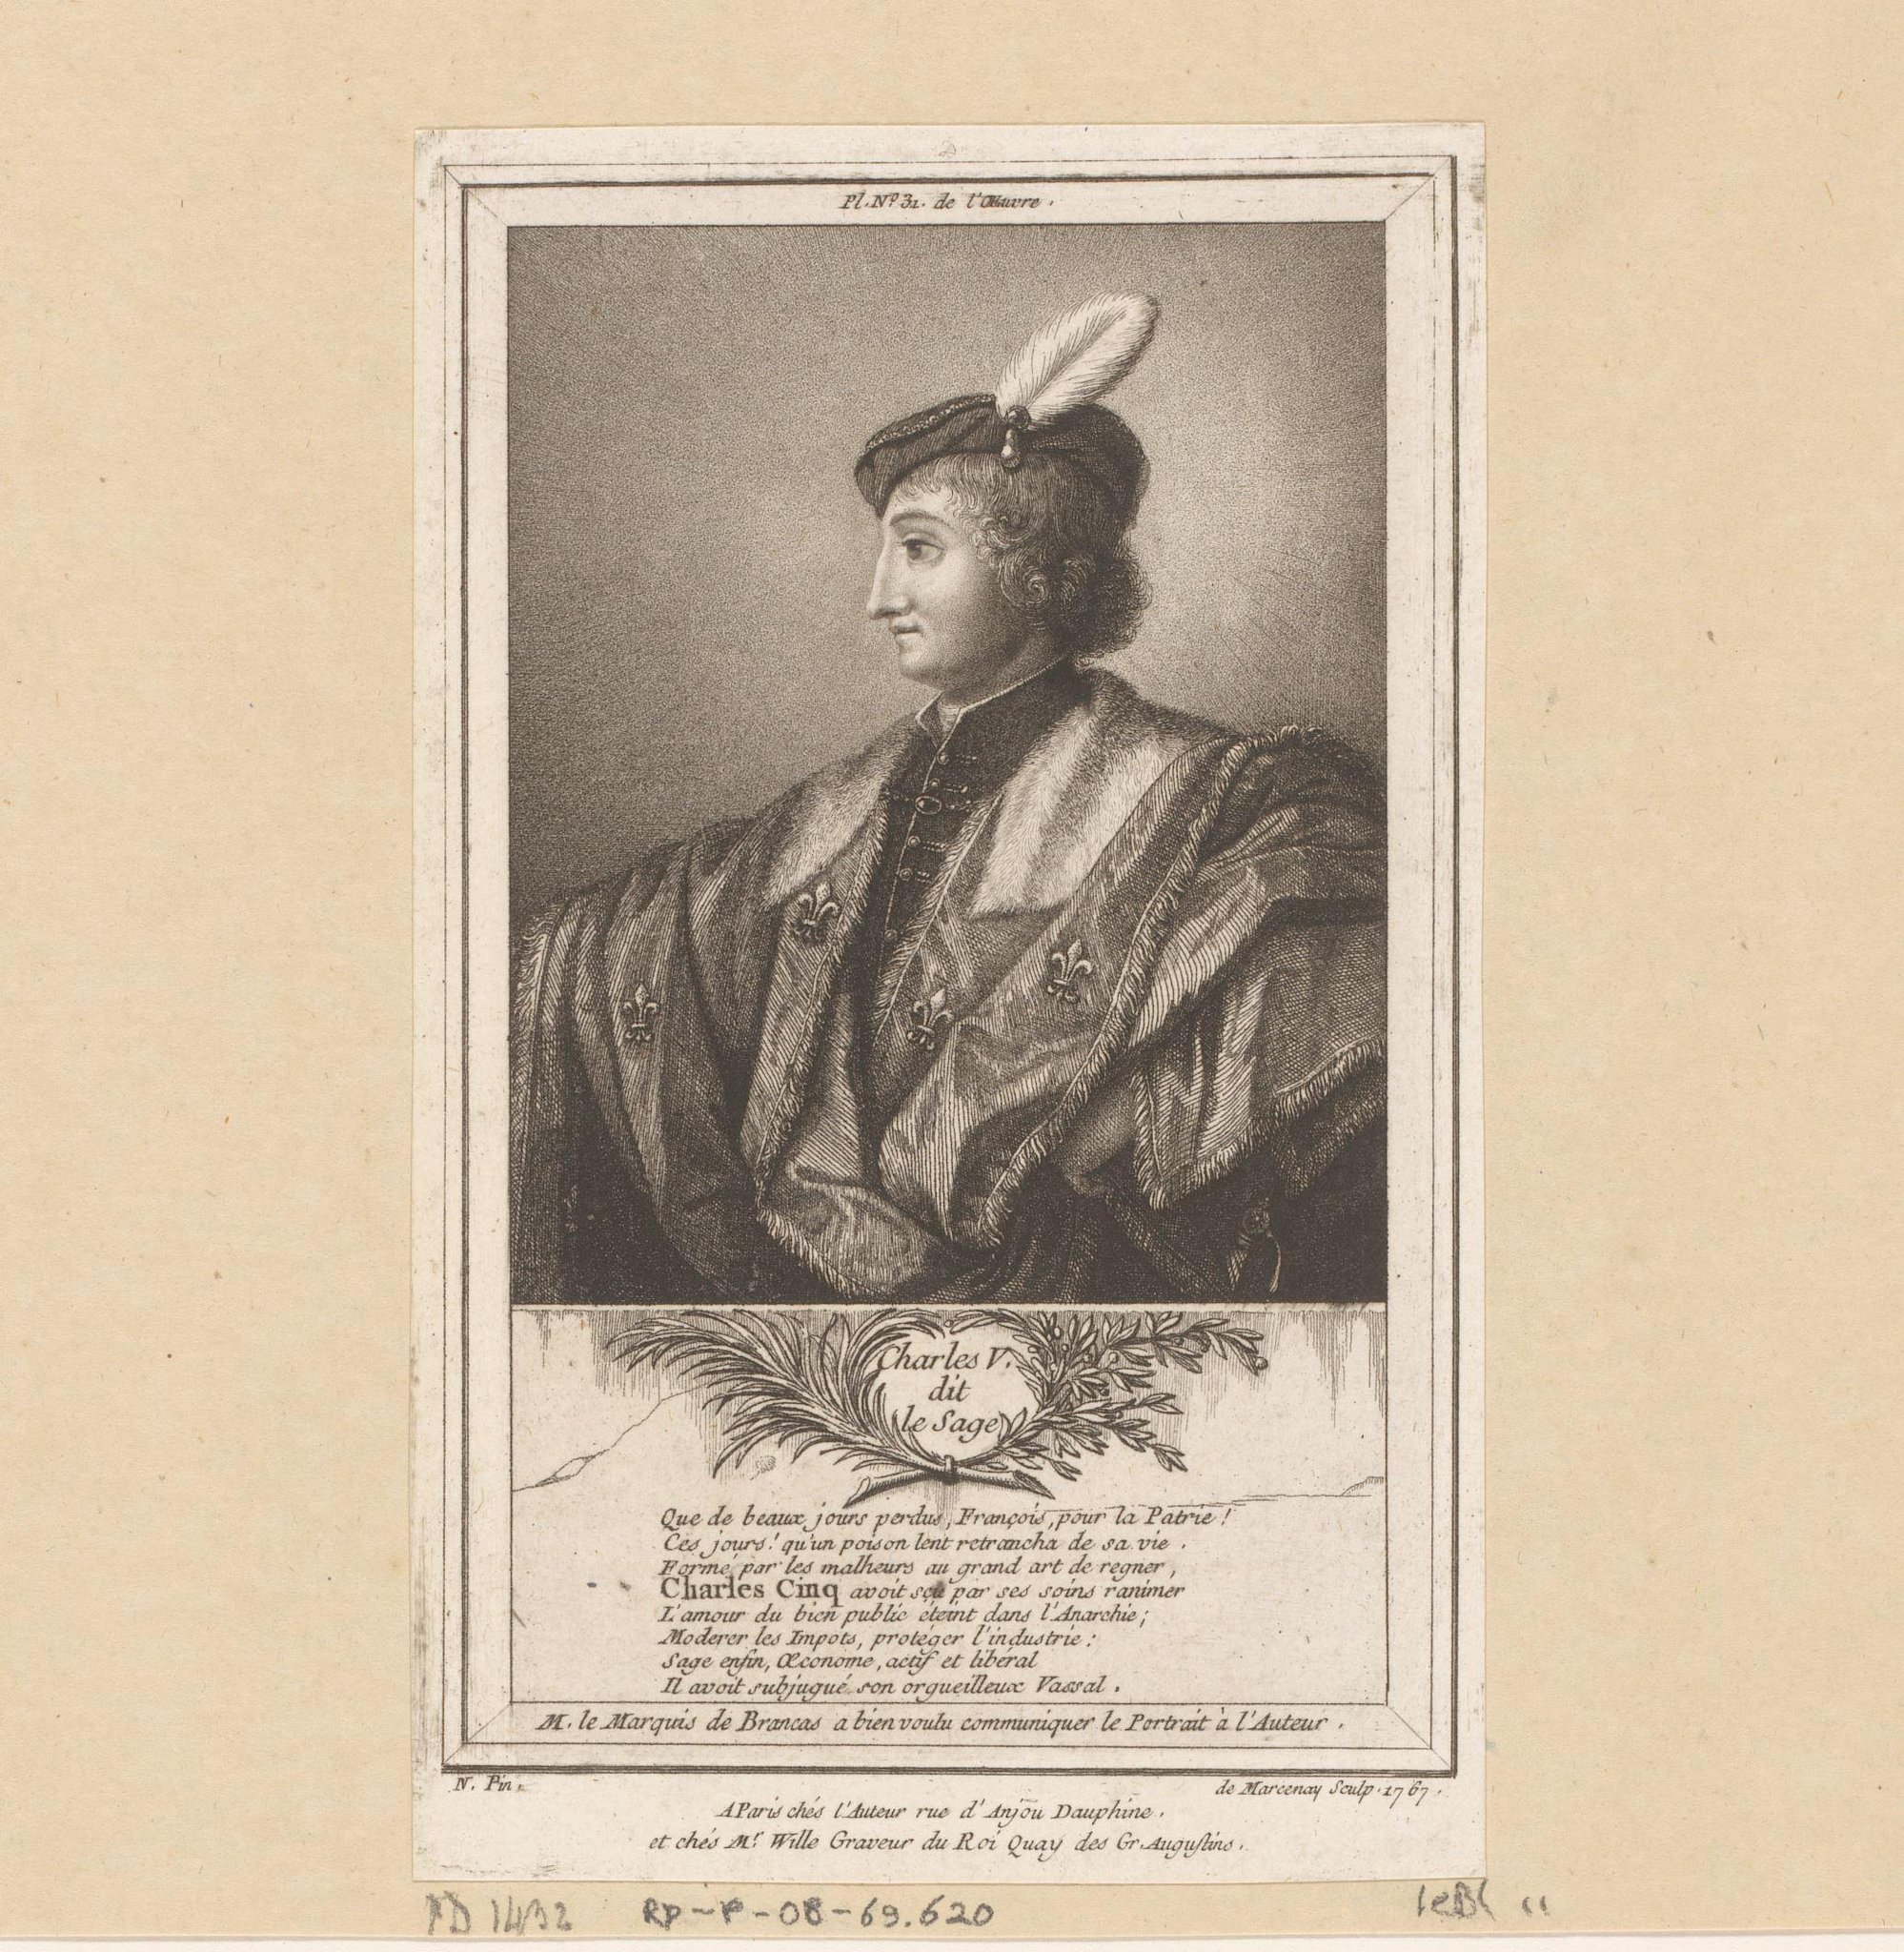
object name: print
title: Portret van Karel V, koning van Frankrijk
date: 1767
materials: paper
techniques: etching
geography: paris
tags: paris, historical persons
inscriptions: collector's mark: Lugt 2228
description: Genummerd midden boven: Pl. No. 31. de l'Oeuvre.